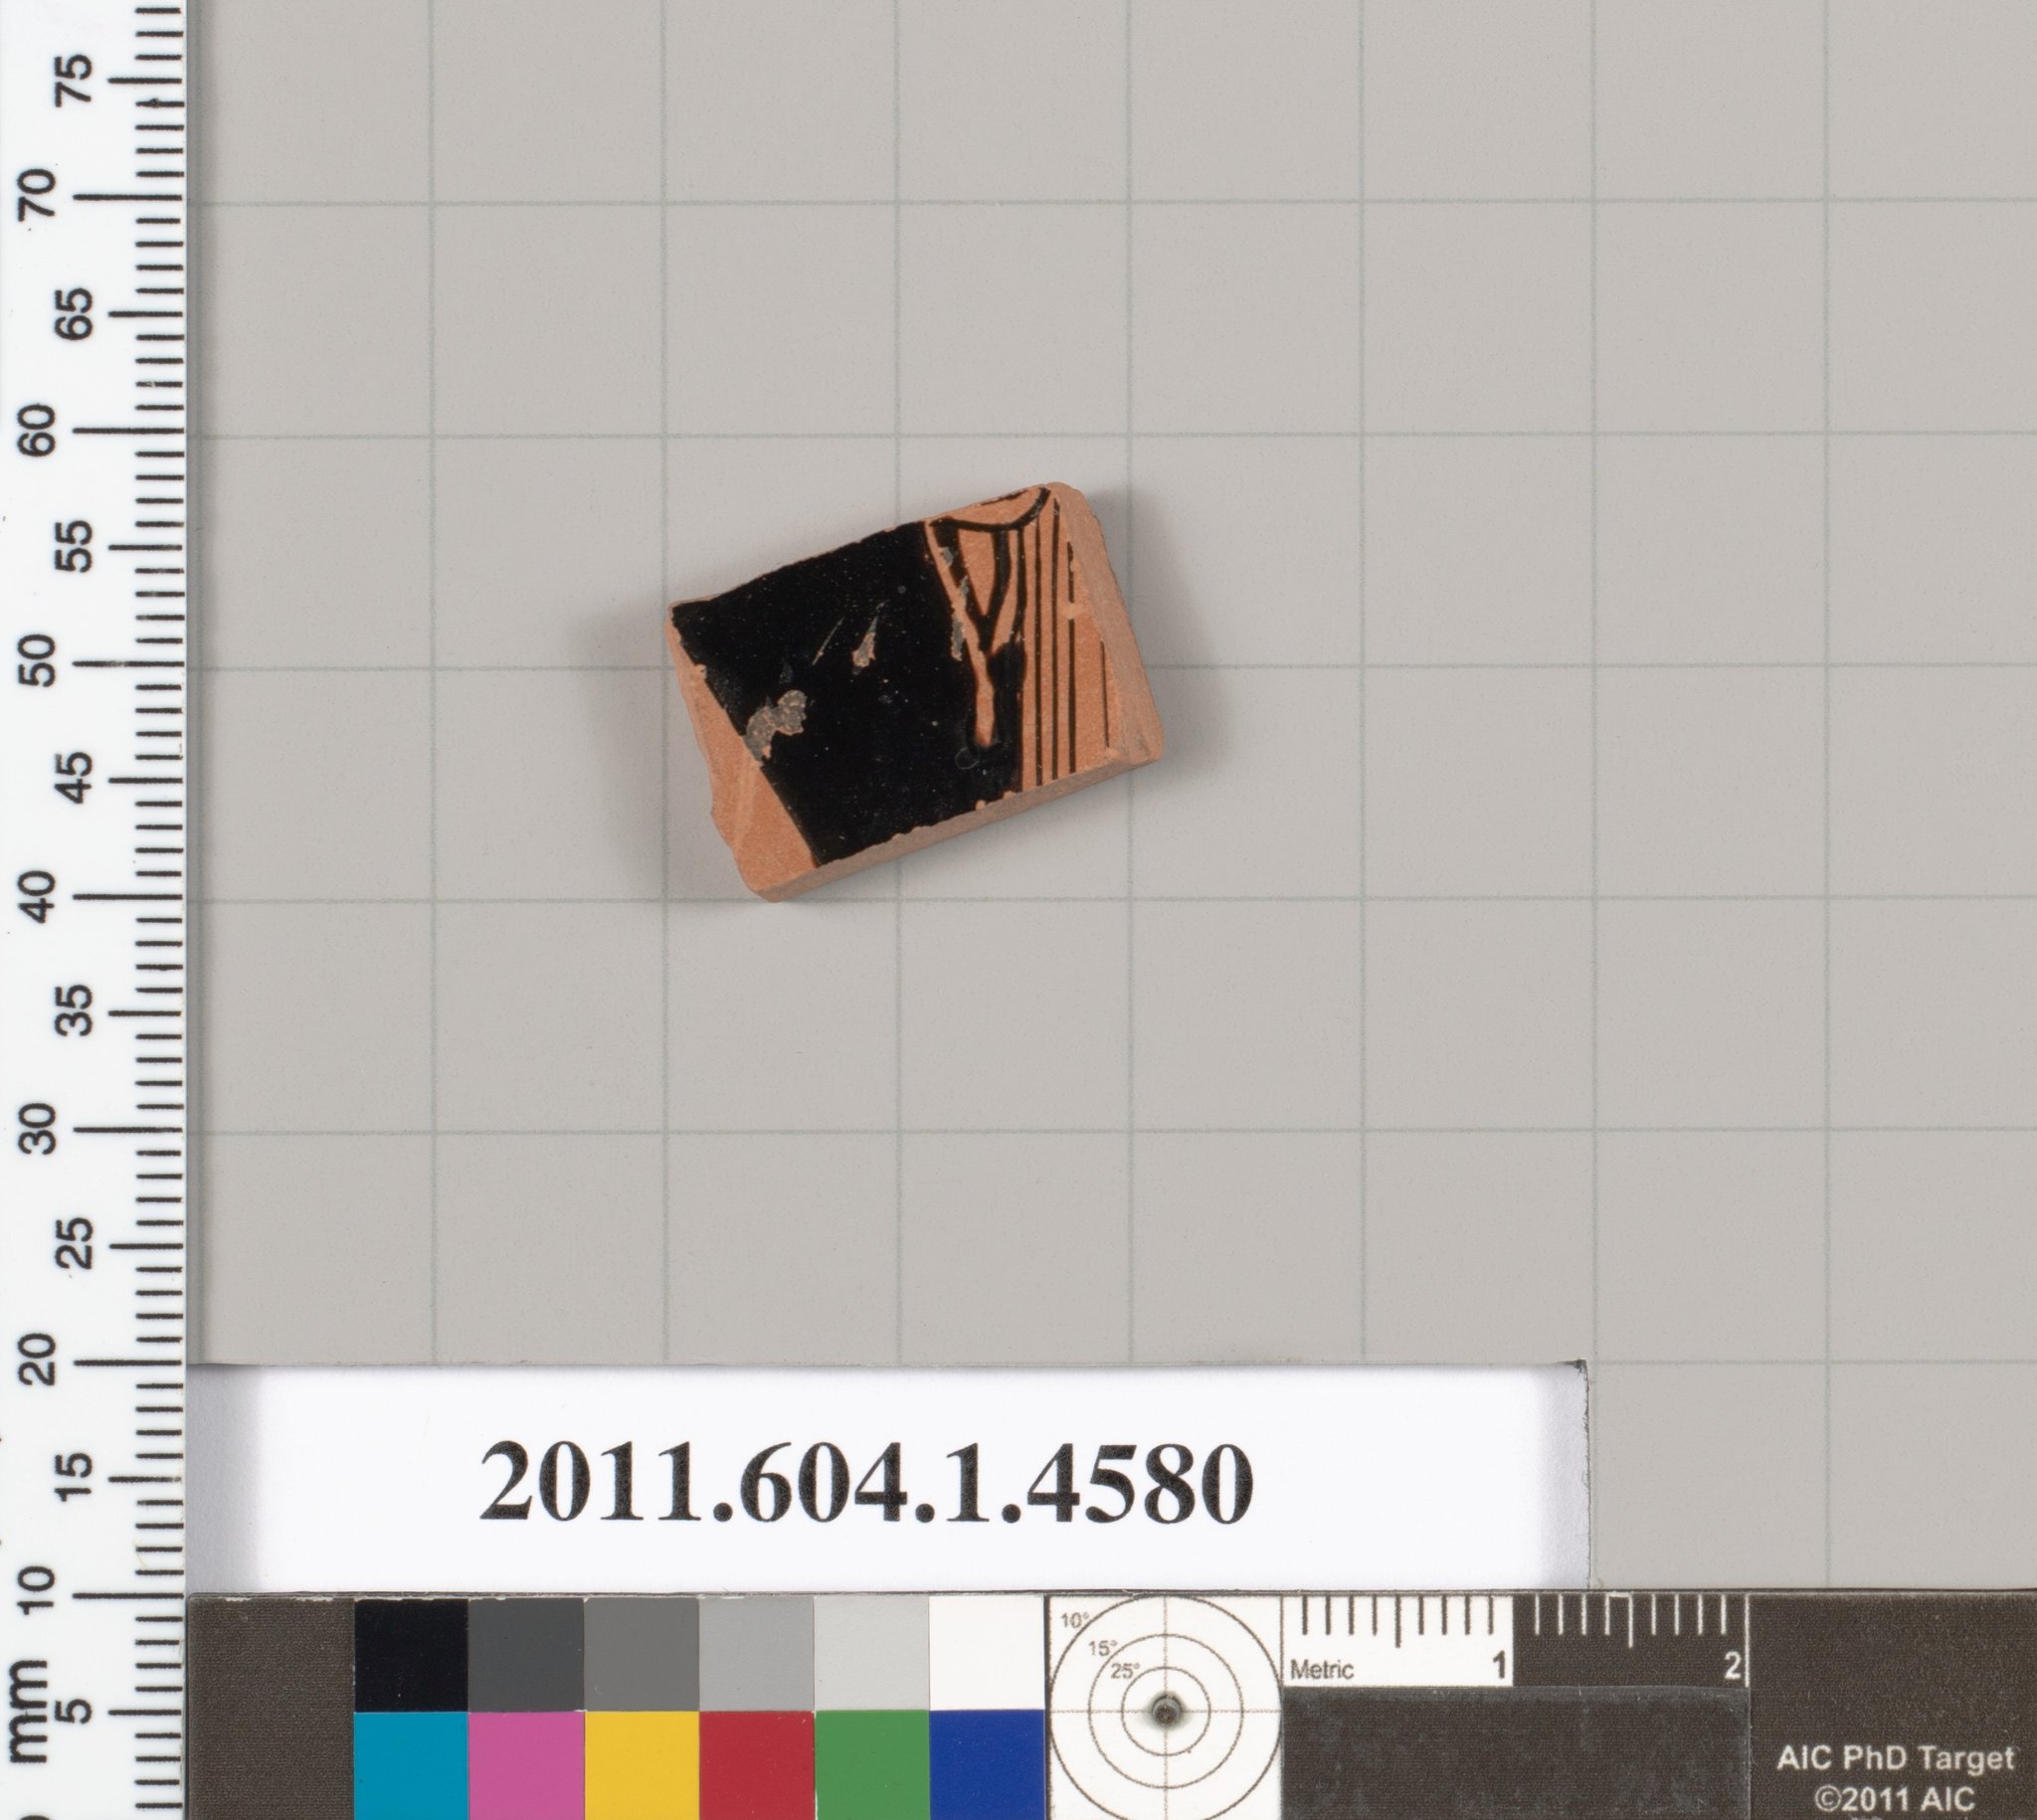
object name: kylix fragment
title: Terracotta fragment of a kylix (drinking cup)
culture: greek, attic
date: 490-470 BCE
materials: terracotta